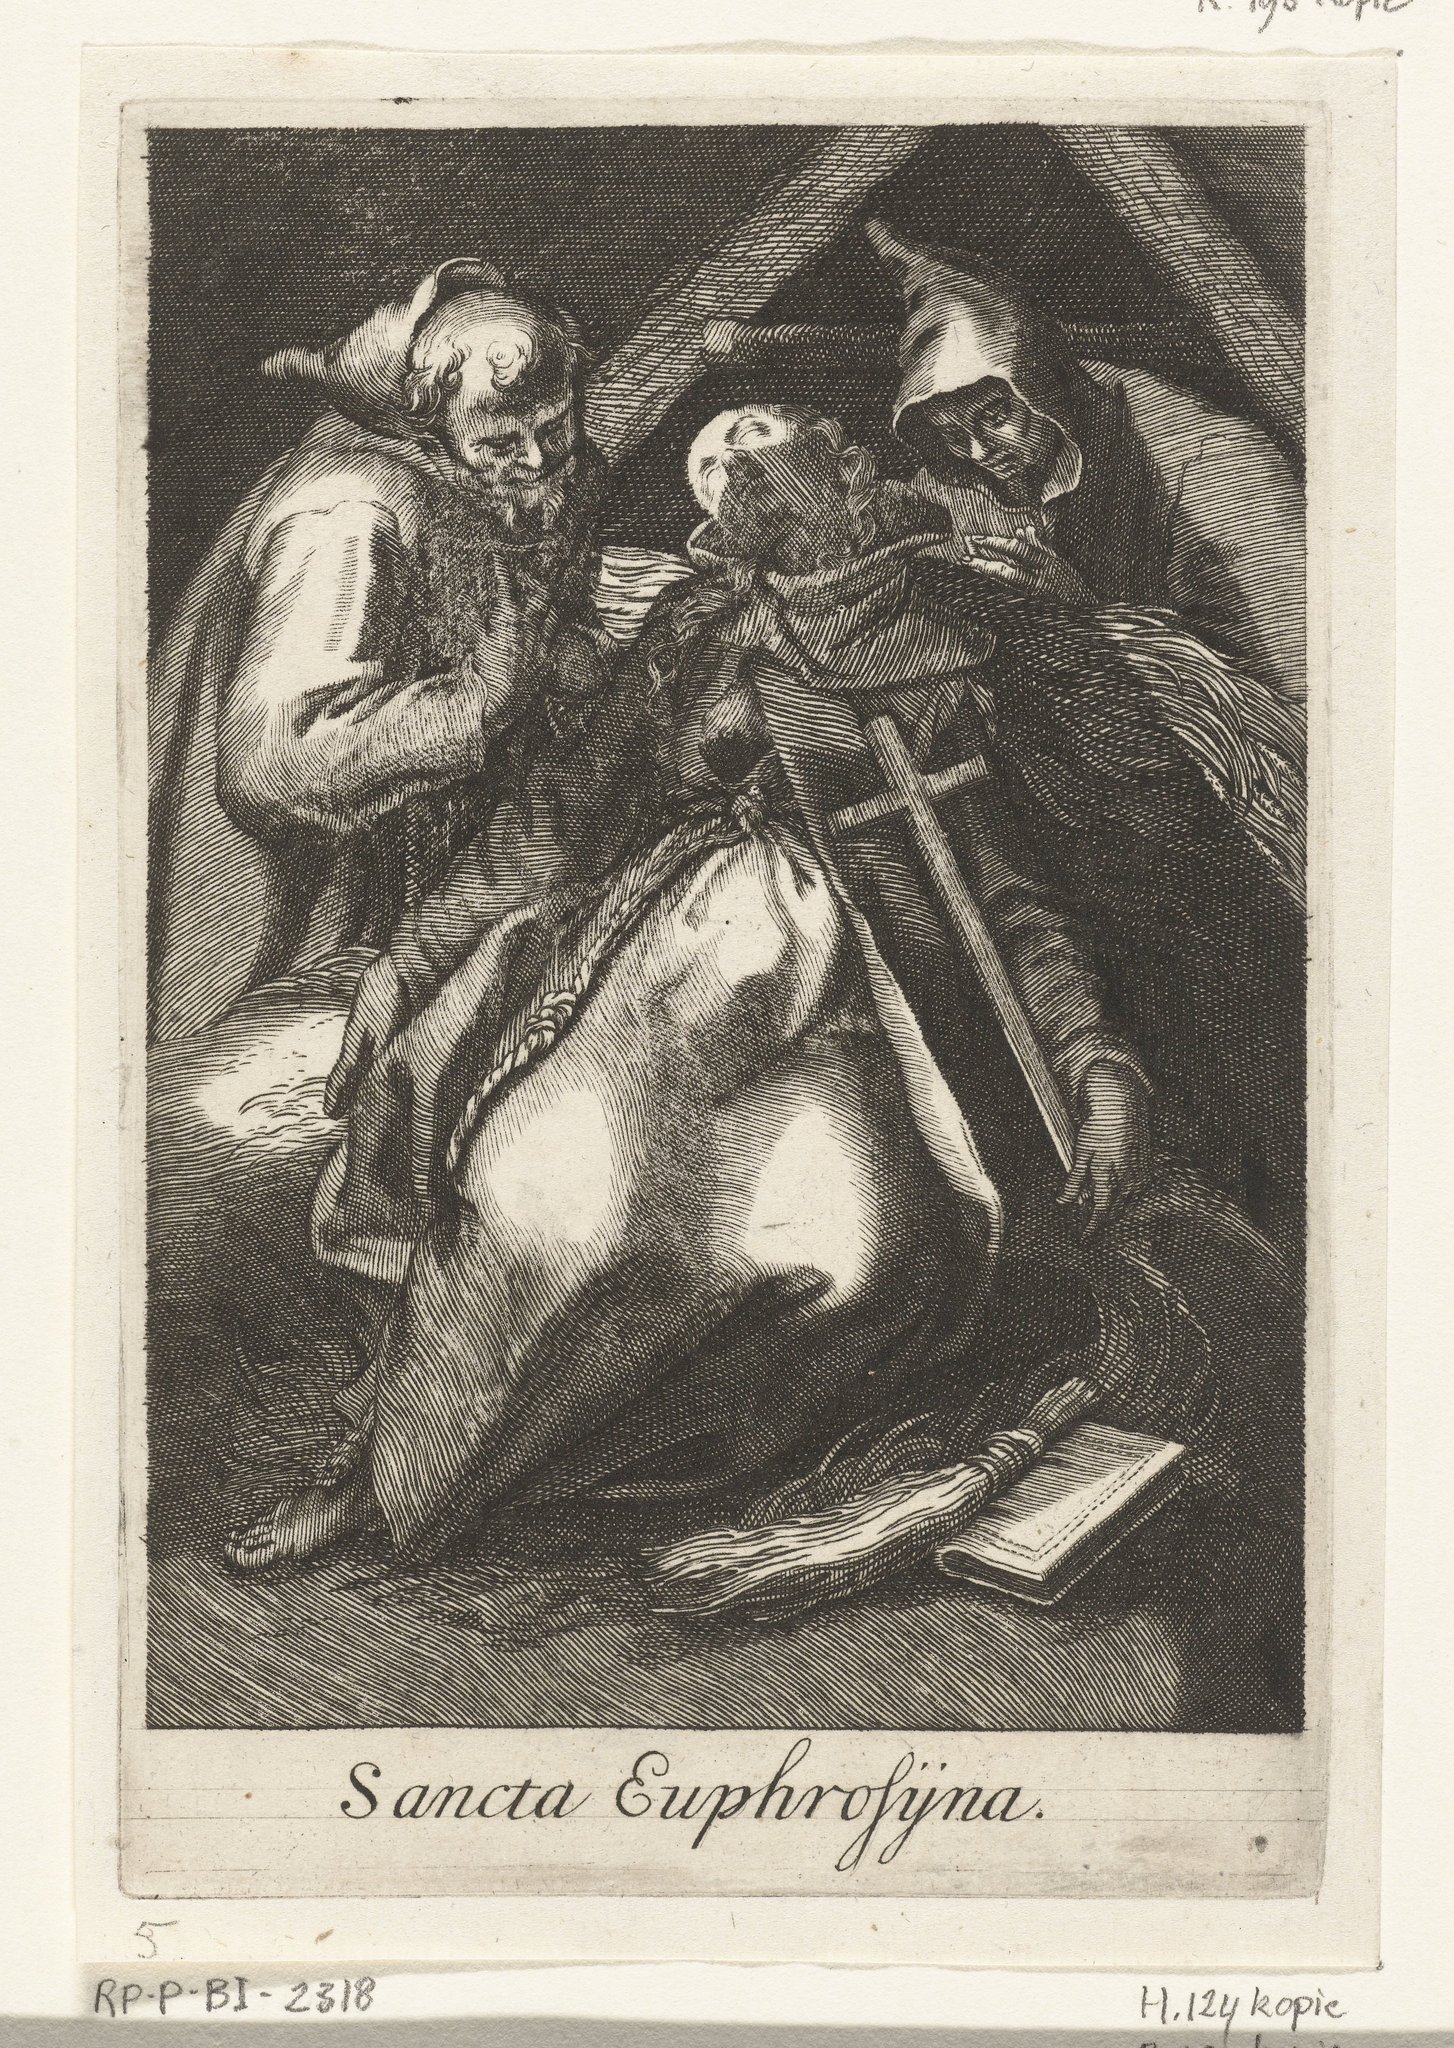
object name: print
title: Heilige Euphrosyna van Alexandrië als kluizenares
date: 1590-1662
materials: paper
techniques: engraving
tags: anchorite, hermit, female saints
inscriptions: collector's mark: Lugt 2228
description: Kopie in spiegelbeeld naar prent van Boëtius Adamsz. Bolswert uit serie Kluizenaressen.